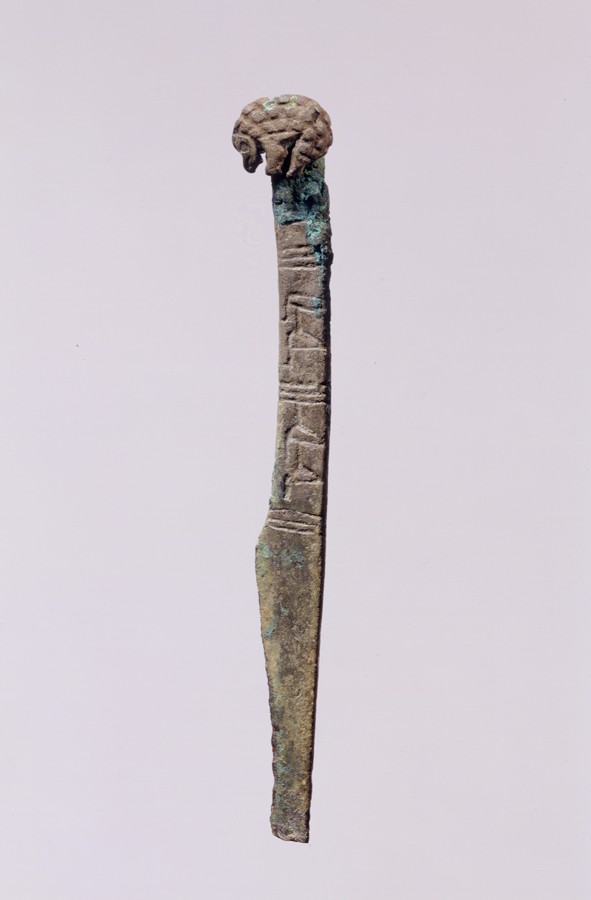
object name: knife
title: Knife with a Hedgehog on the Handle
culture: chinese, northeast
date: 700-401 BCE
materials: bronze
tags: animals,knives